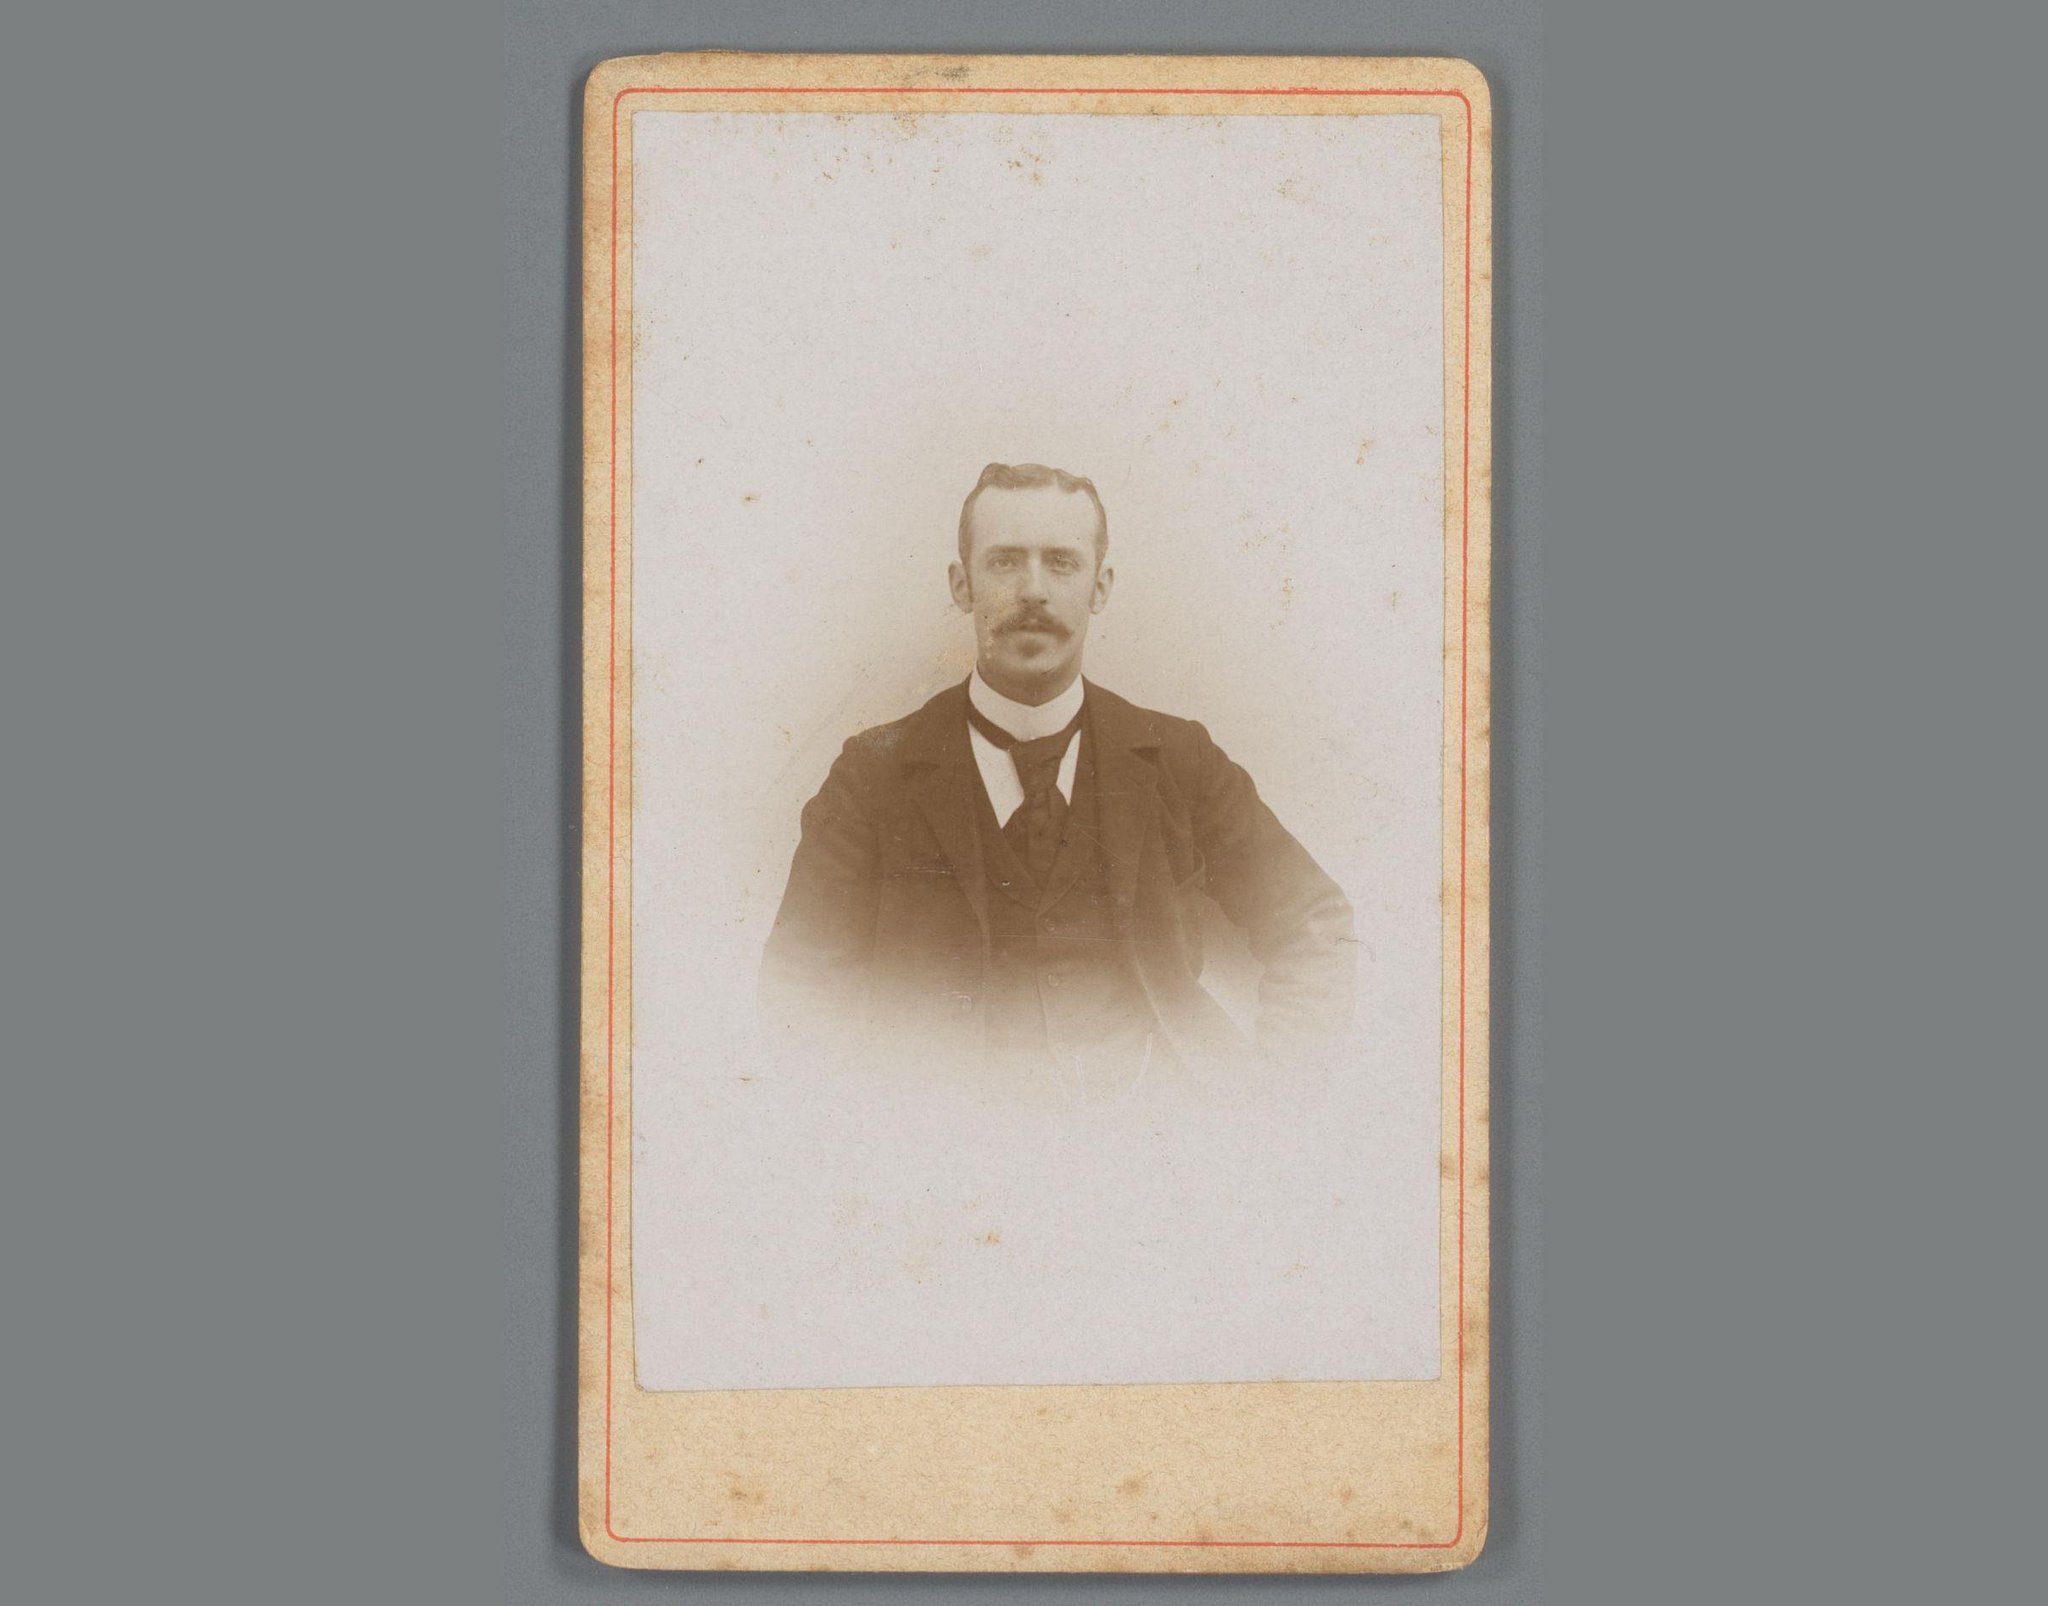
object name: carte de visite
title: Portret van een onbekende man, mogelijk een lid van de familie Onnen-van den Berg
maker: Anonymous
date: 1885-1914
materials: paper, cardboard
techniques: collodion silver print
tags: anonymous historical person portrayed